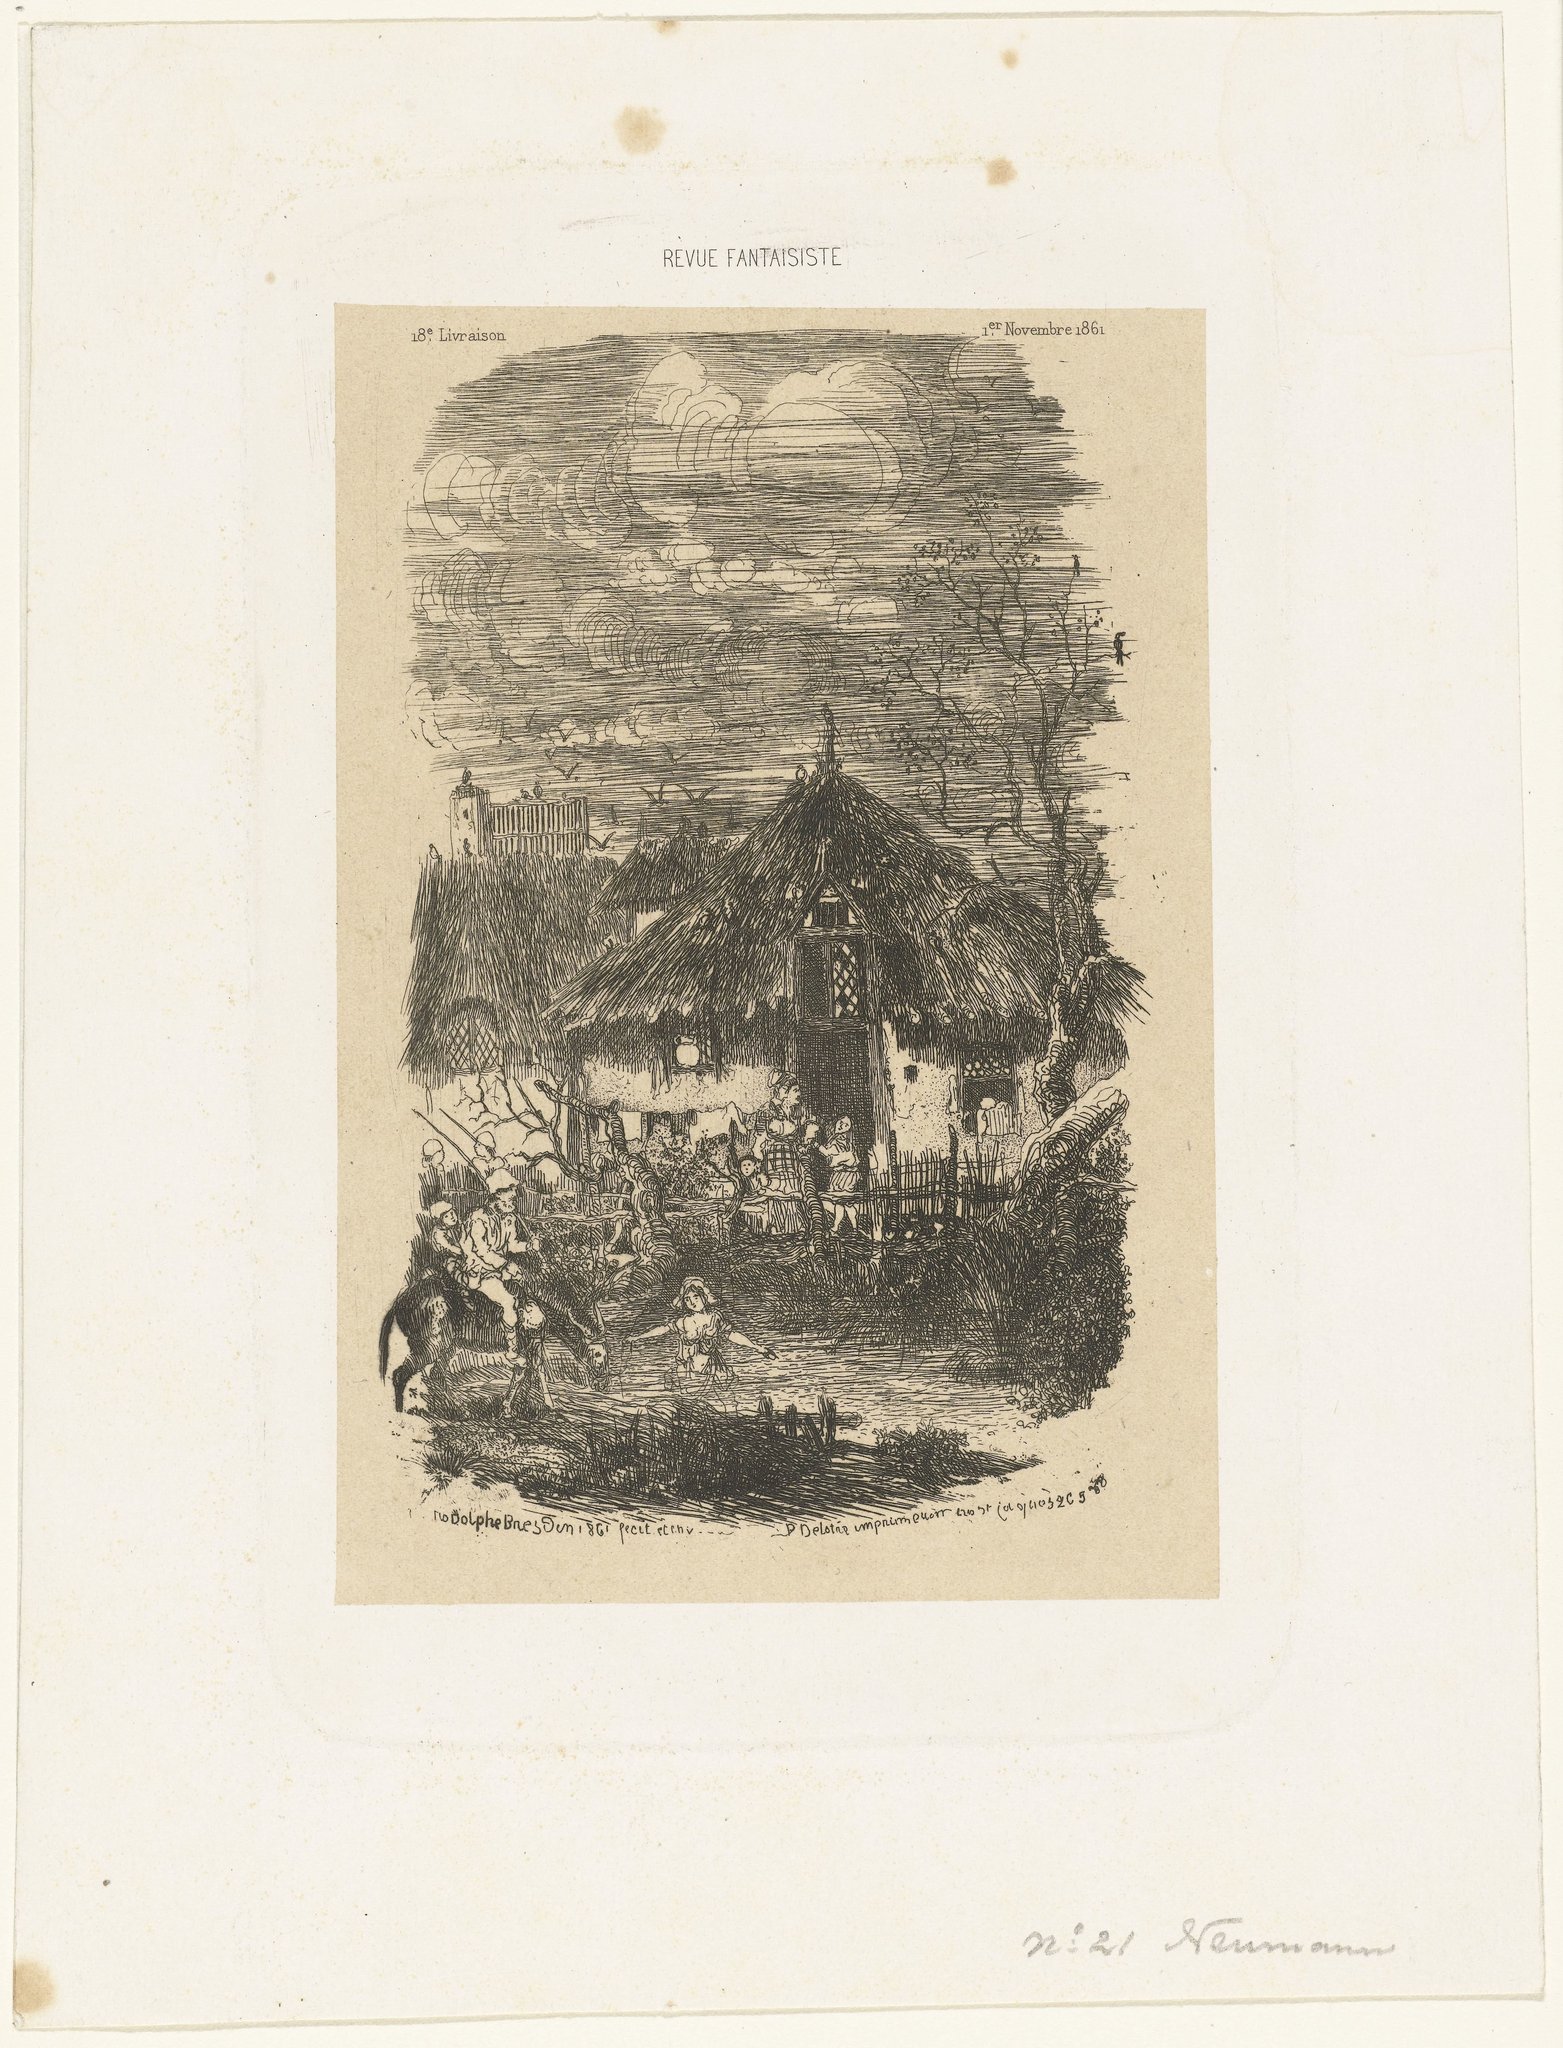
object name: print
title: Pavillon de ferme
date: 1861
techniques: printmaking, etching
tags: farm or solitary house in landscape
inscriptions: collector's mark: Lugt 2228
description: Boerderij met erf waar een boerin de was op hangt en kinderen kijken naar passerende reizigers zoals een man op een ezel links die het dier laat drinken. In de waterplas op de voorgrond staat een vrouw tot haar middel in het water. Boven de voorstelling staat de tekst Revue Fantaisiste.